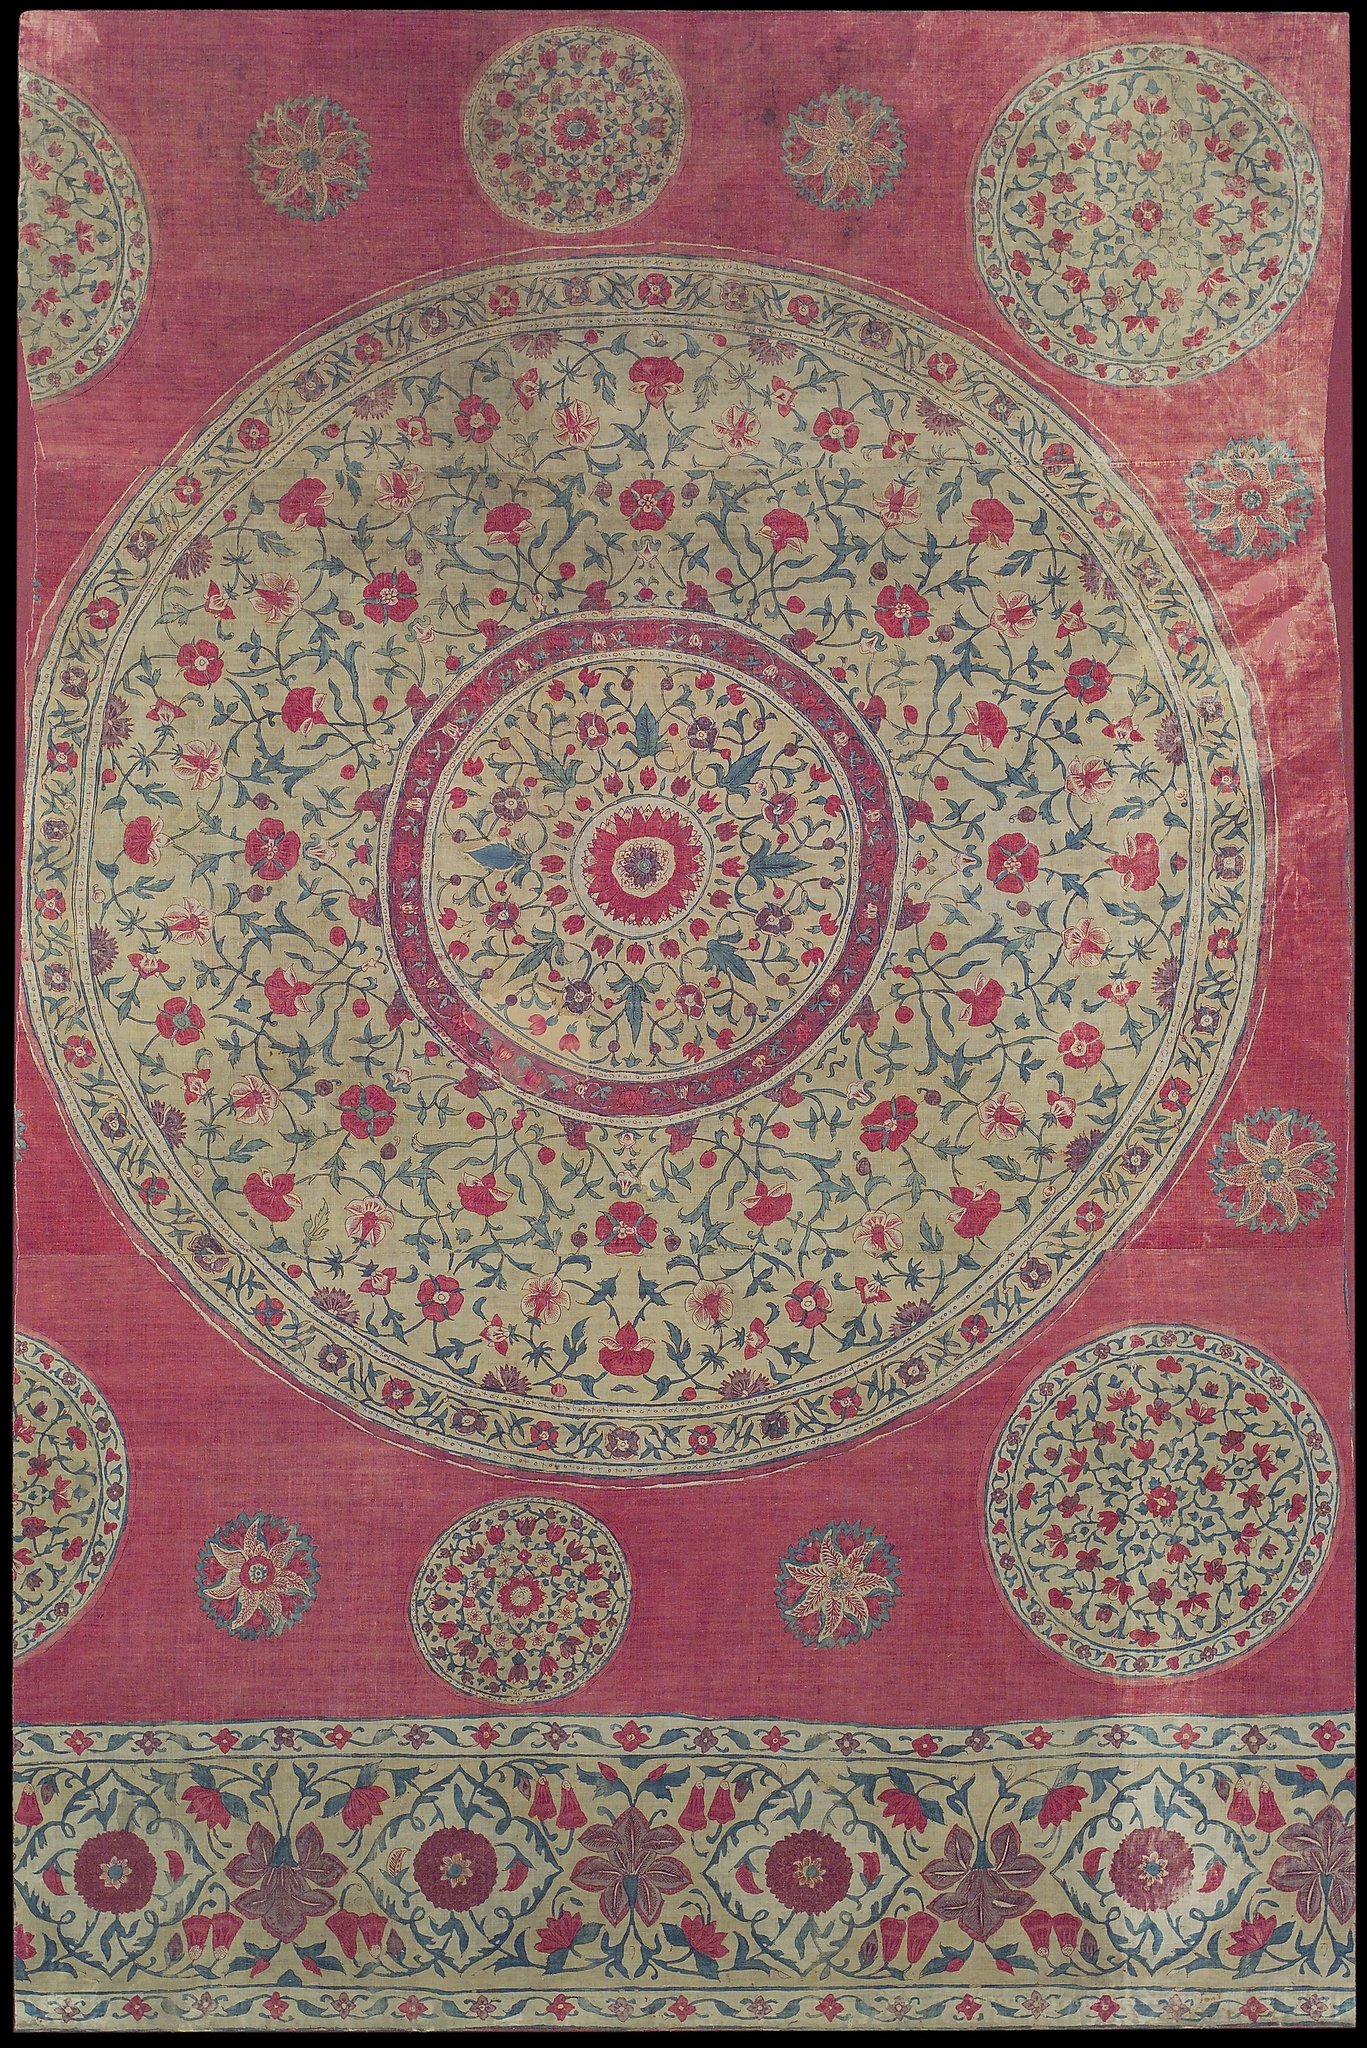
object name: tent panel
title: Panel of a Tent Lining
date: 1700-1740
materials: cotton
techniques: dyeing, painting, weave, resist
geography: india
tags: flowers